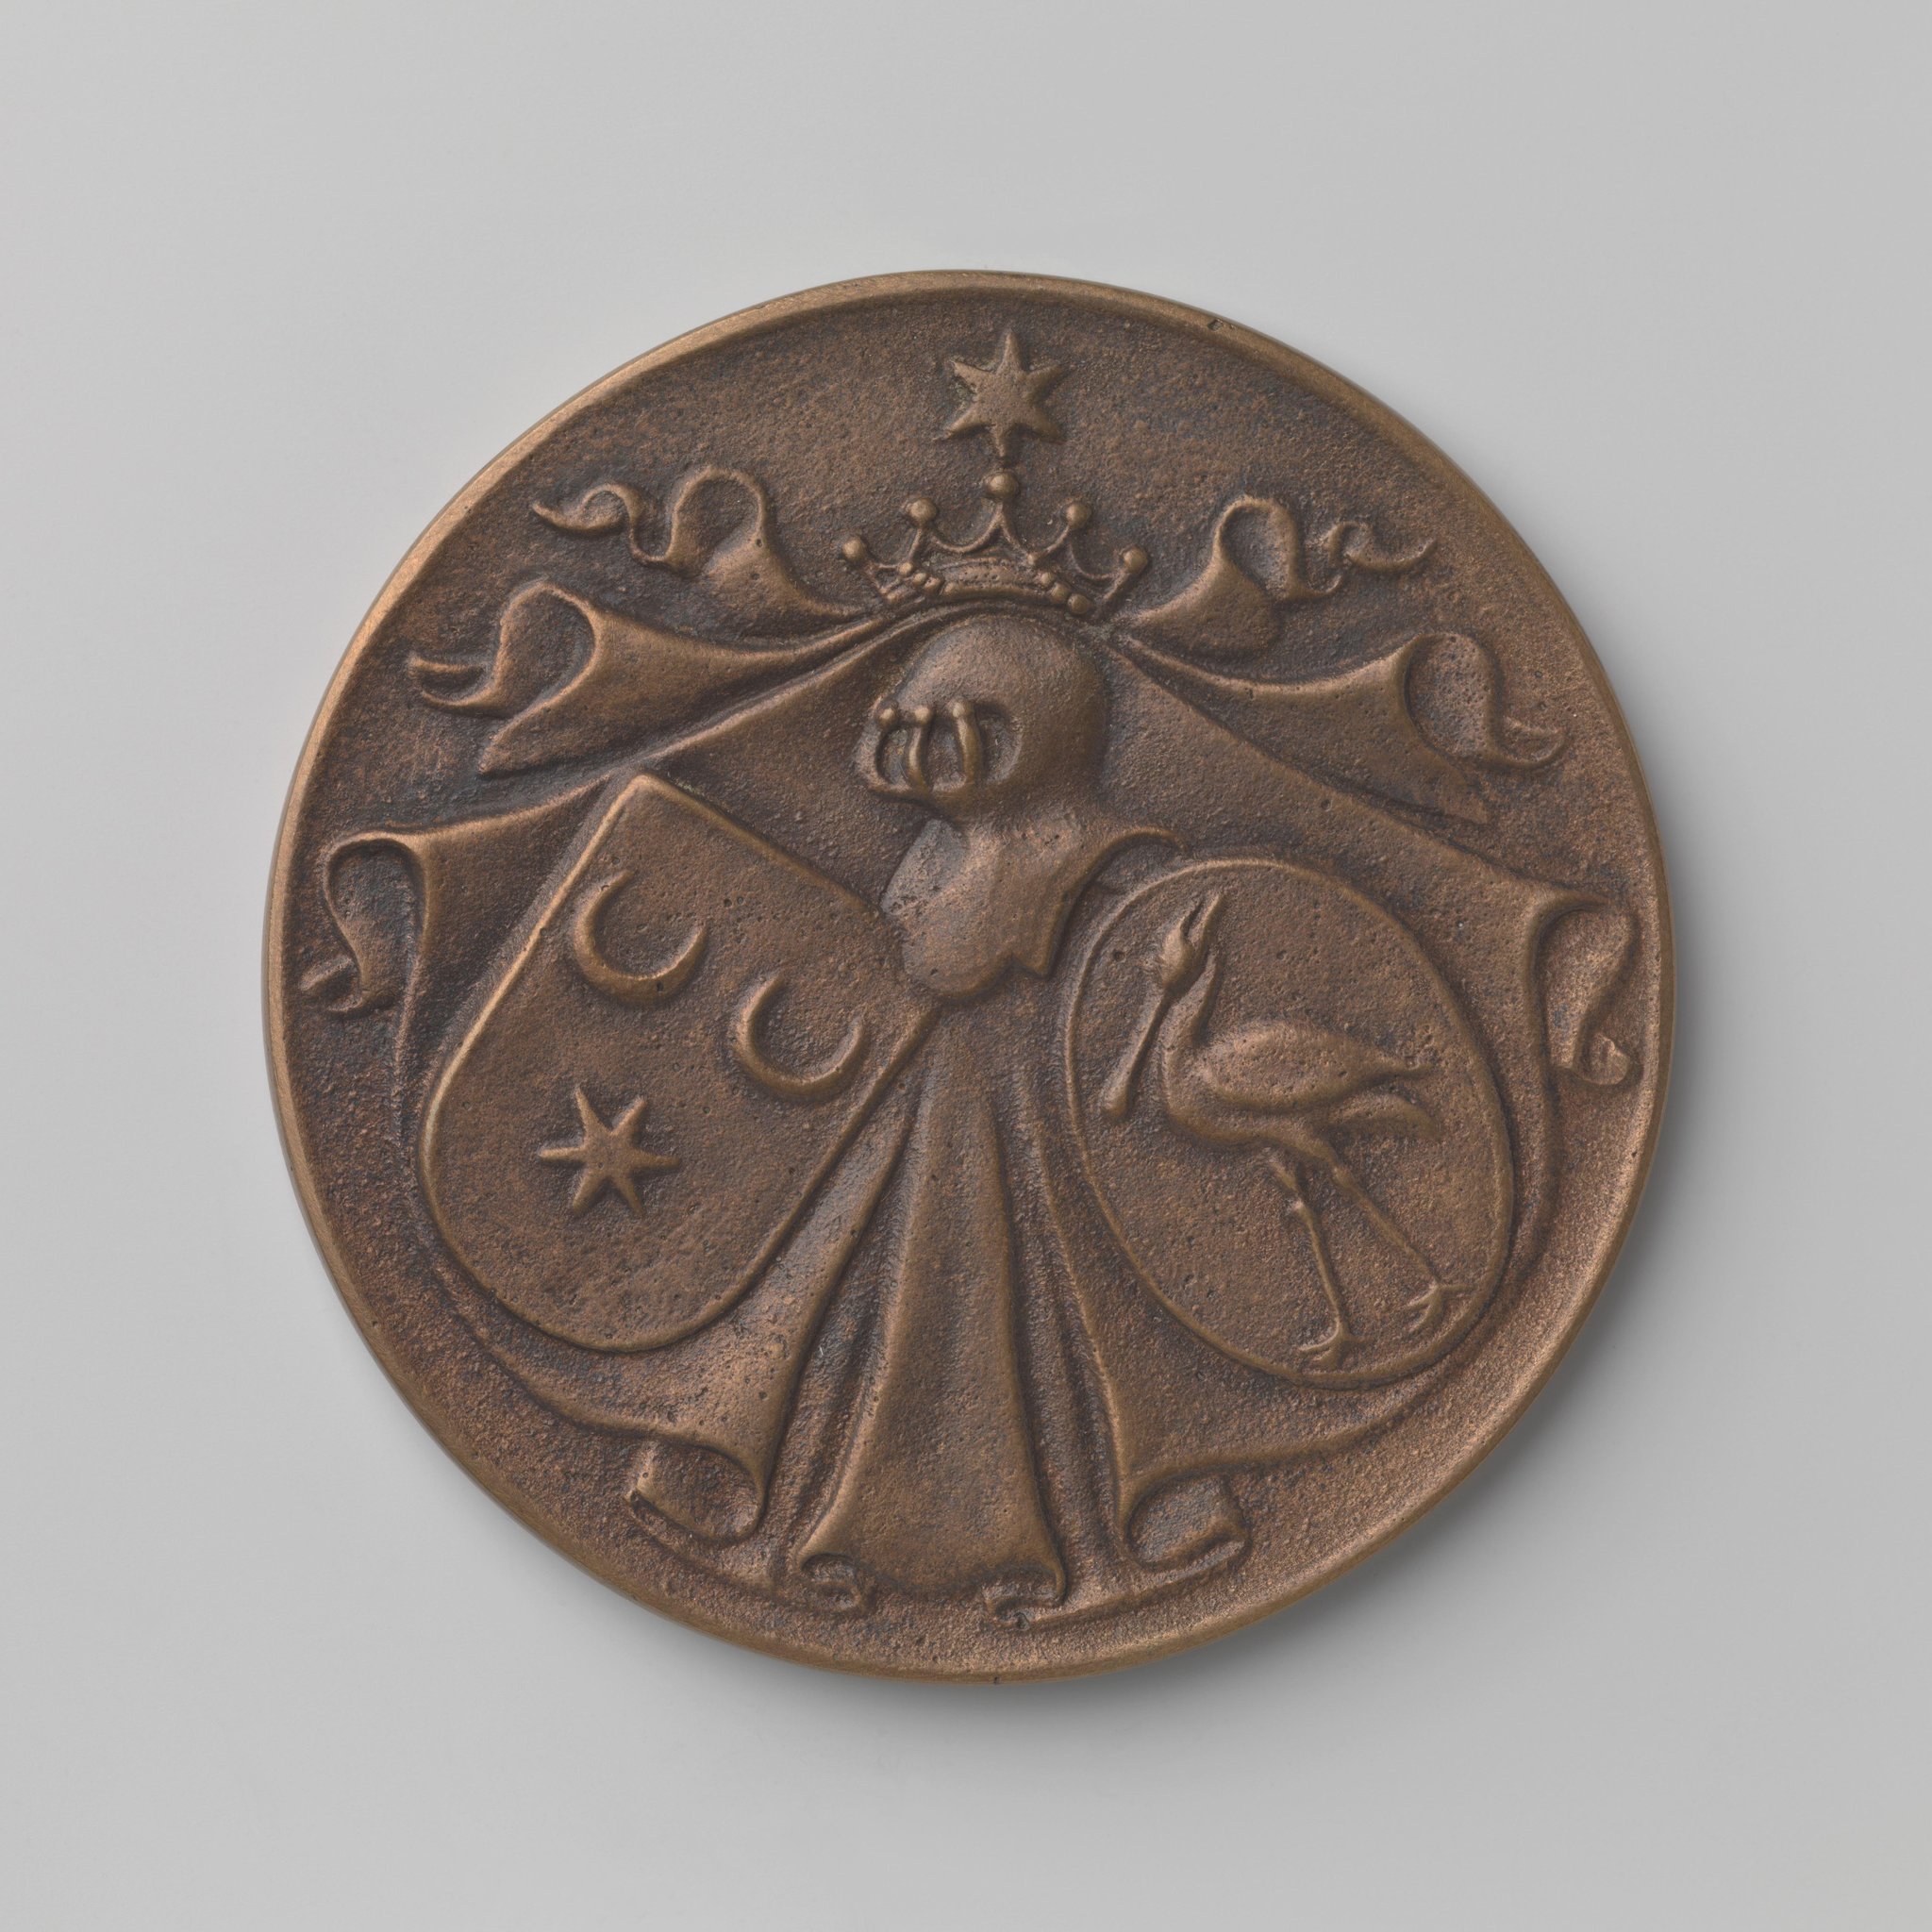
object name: history medal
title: Koperen huwelijk van Gijsbert Christiaan Six van Wimmenum en Anne Maurice Adrienne Repelaer 1934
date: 1934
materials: bronze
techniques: casting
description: Bronzen gegoten penning, op de voorzijde twee wapenschilden onder één helm op een gekroonde mantel, op de keerzijde elf regels tekst.